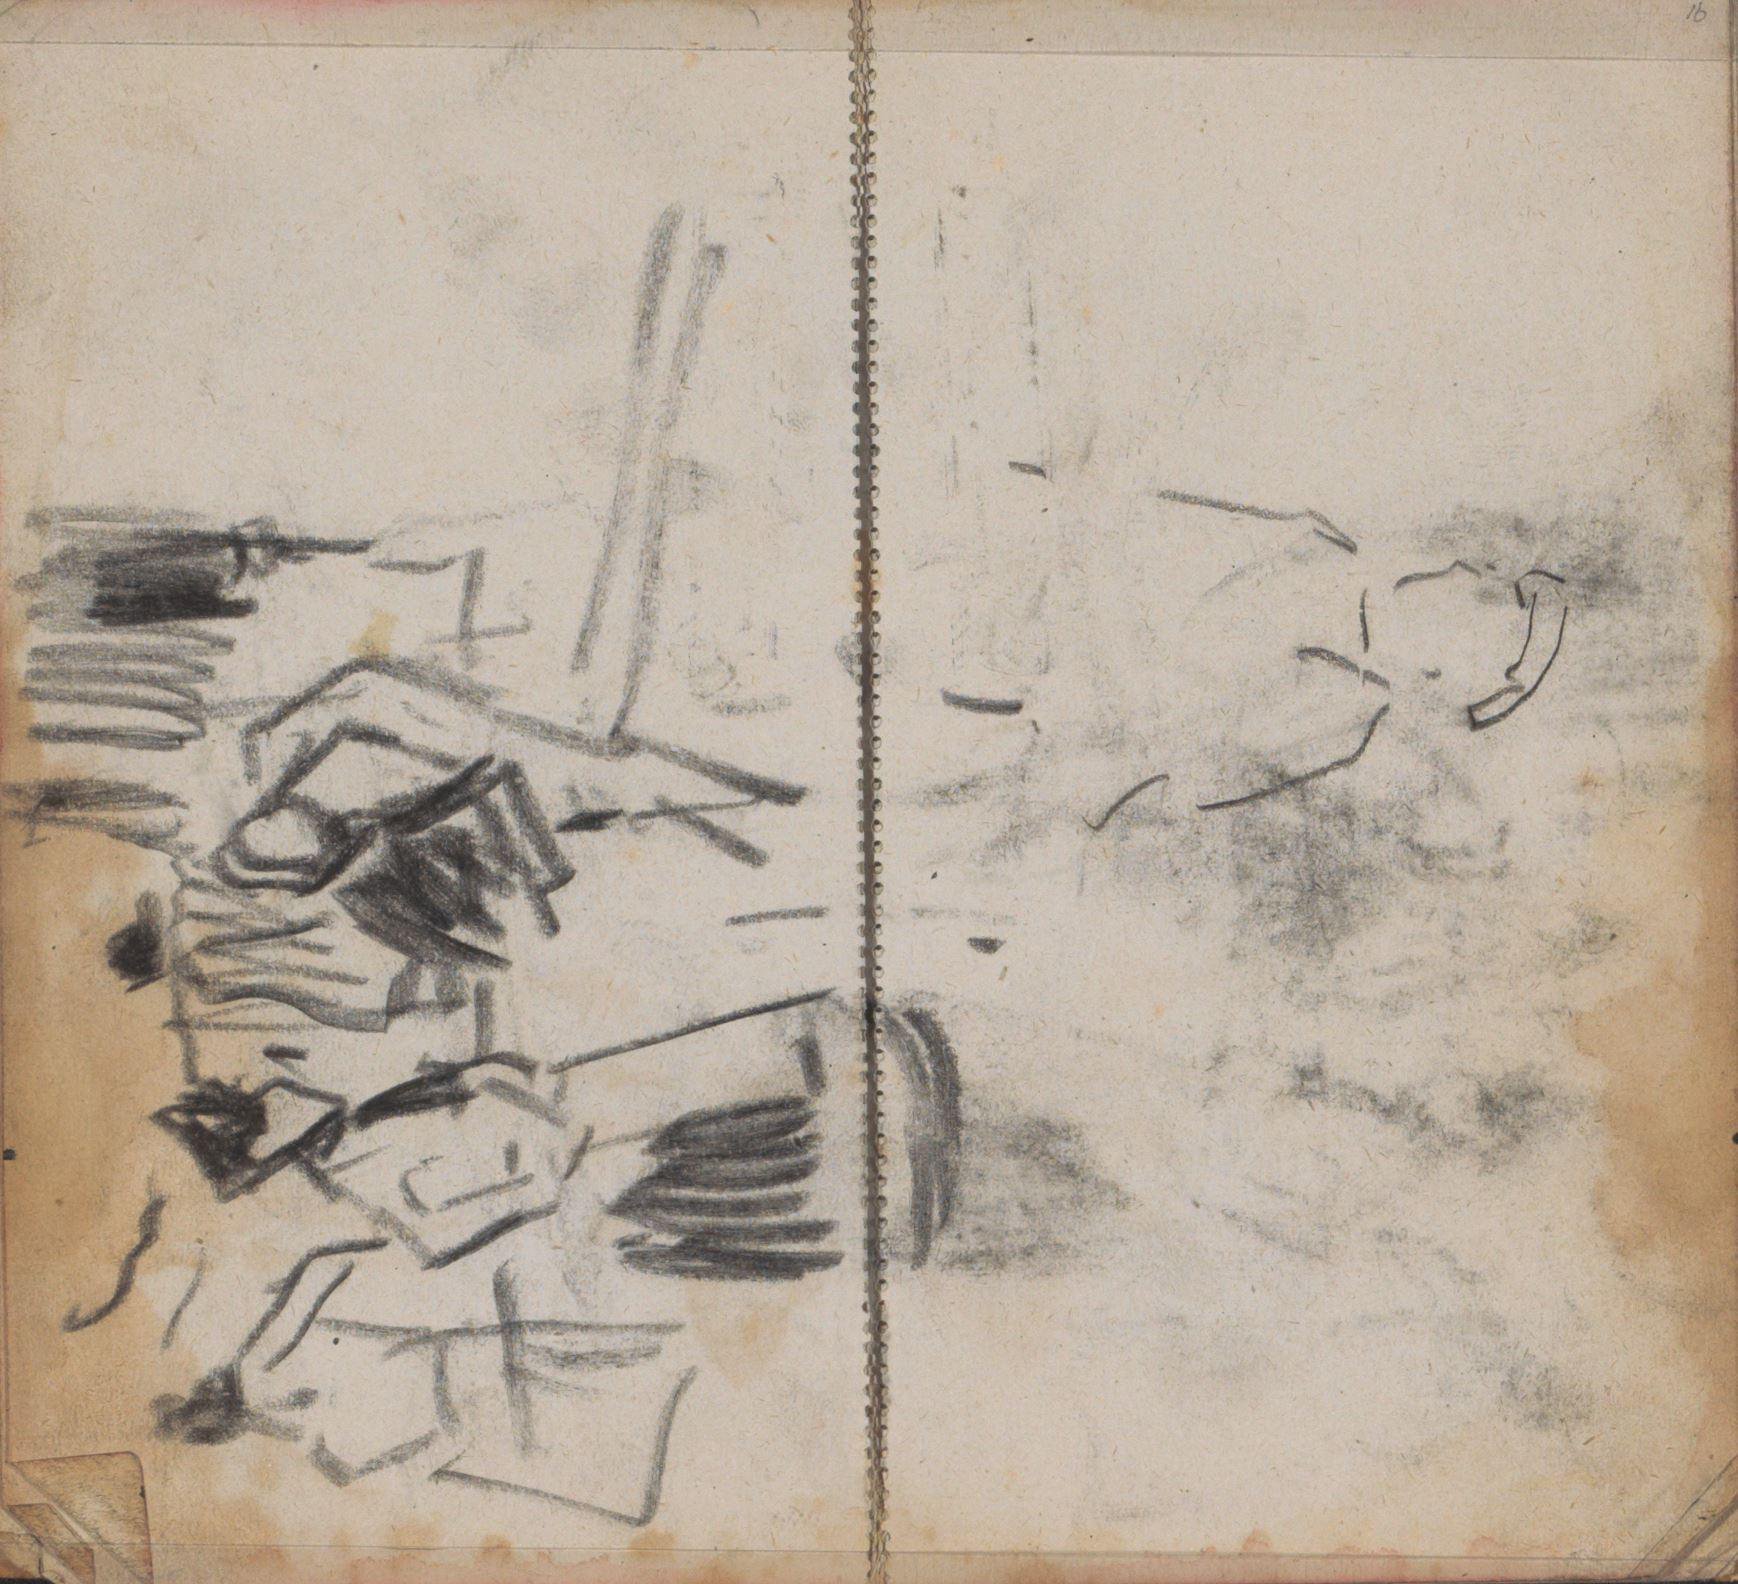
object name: sketchbook leaf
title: Figuurstudies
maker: george hendrik breitner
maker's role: draughtsman, painter, print maker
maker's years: 1857-1923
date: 1893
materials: chalk, paper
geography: amsterdam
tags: adult woman, adult man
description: Figuurstudies. Pagina 15 en pagina 16 uit een schetsboek met 22 bladen vervaardigd te Amsterdam.